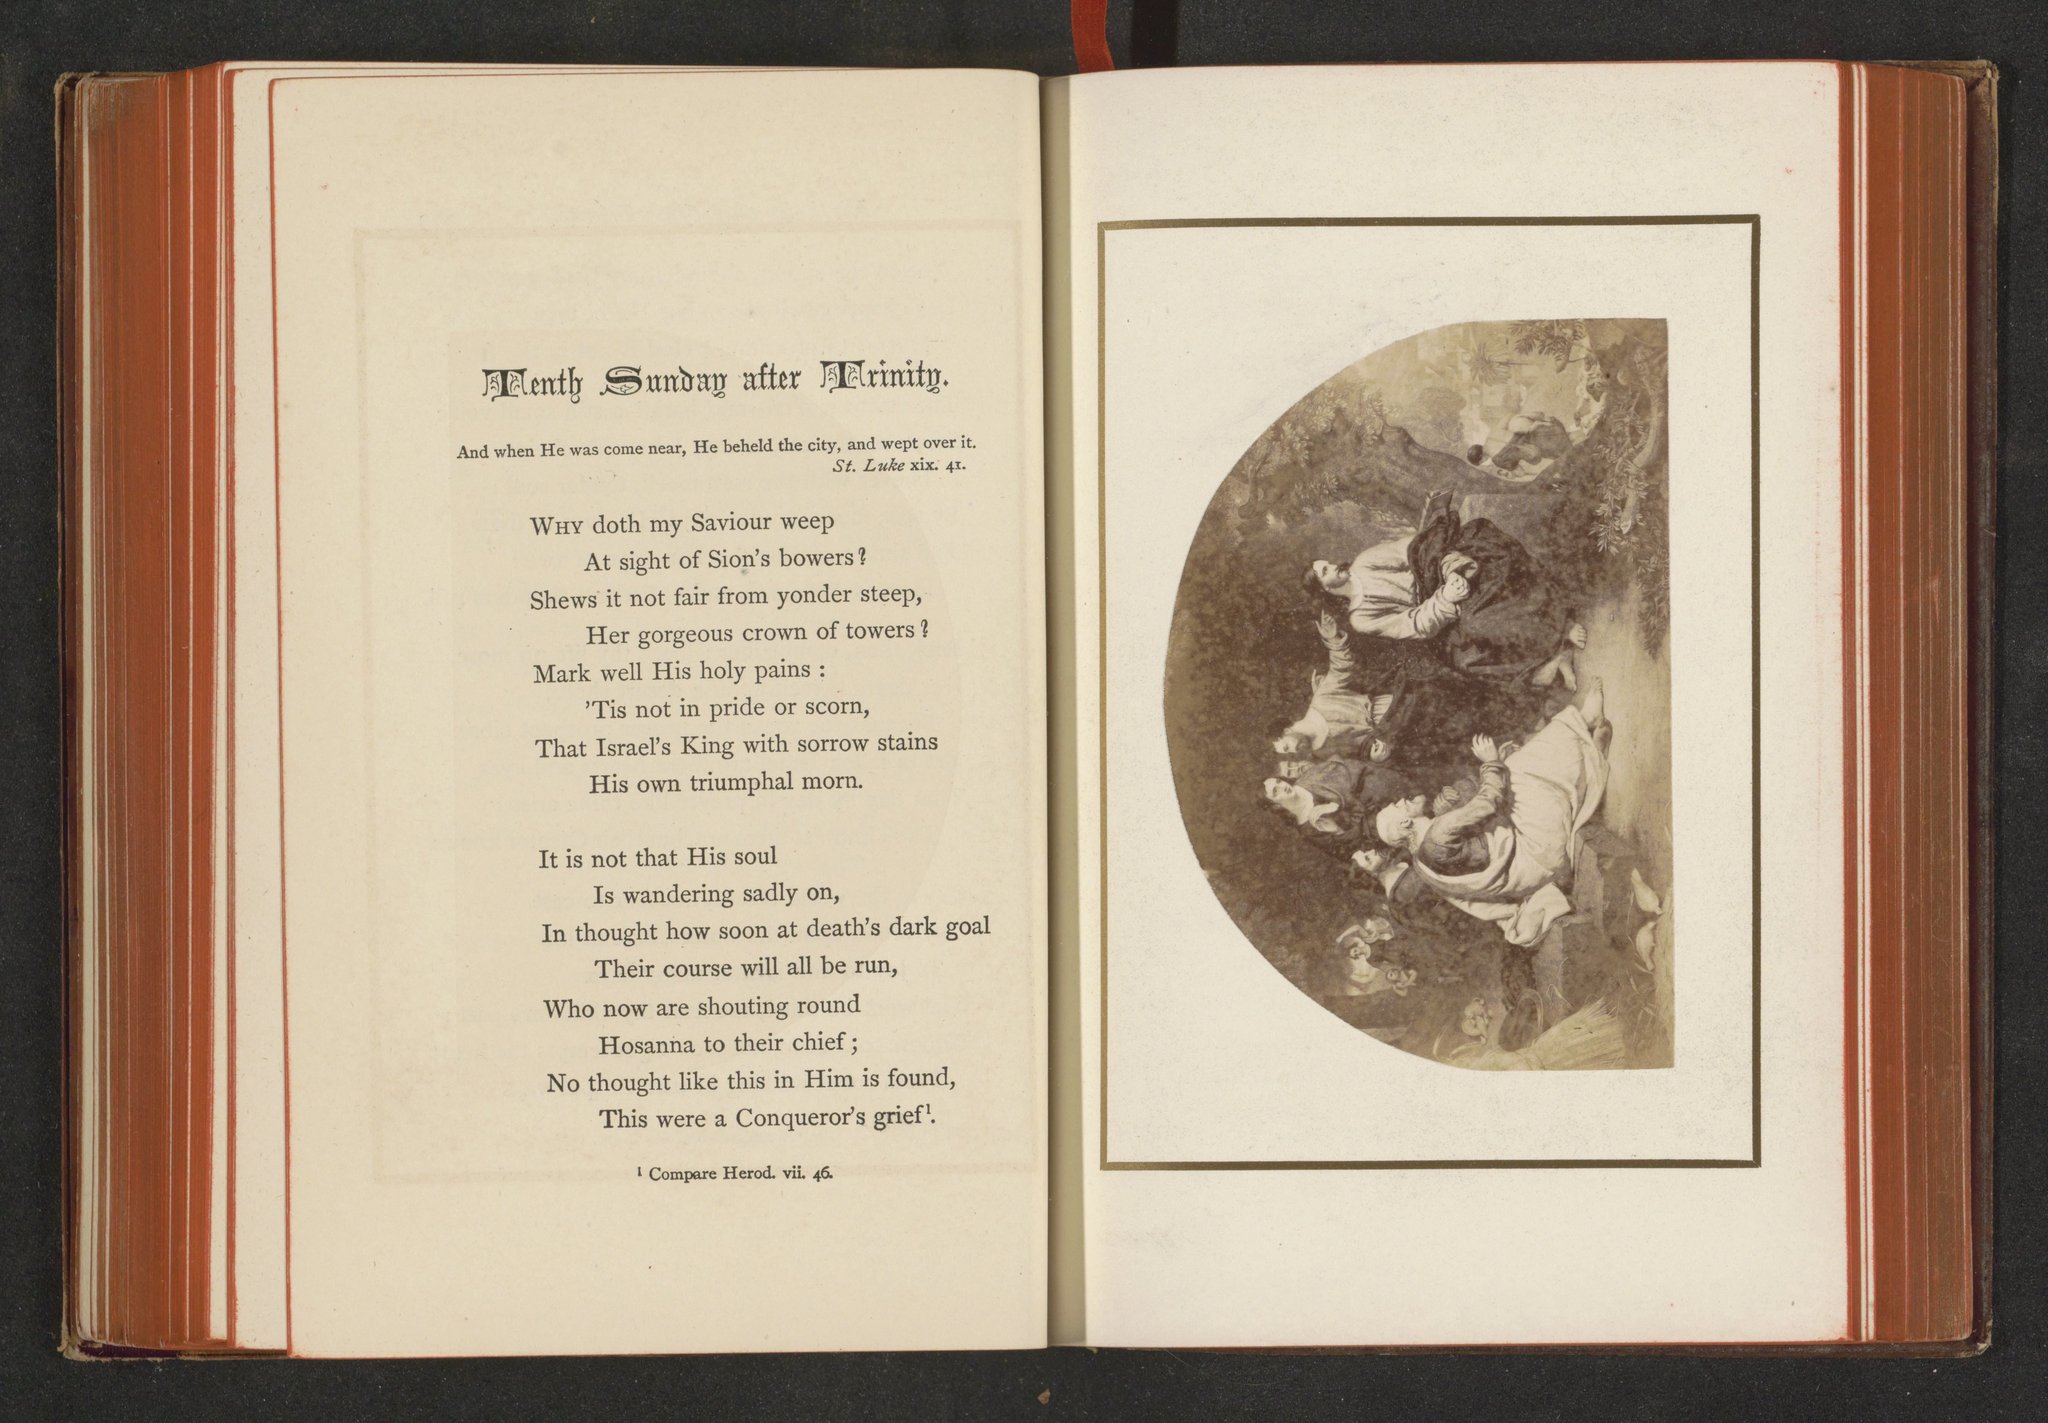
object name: page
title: Fotoreproductie van een prent, voorstellende Christus met zijn discipelen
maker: Anonymous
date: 1870-1875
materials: photographic support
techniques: albumen print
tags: christ explaining his doctrine to the apostles and disciples